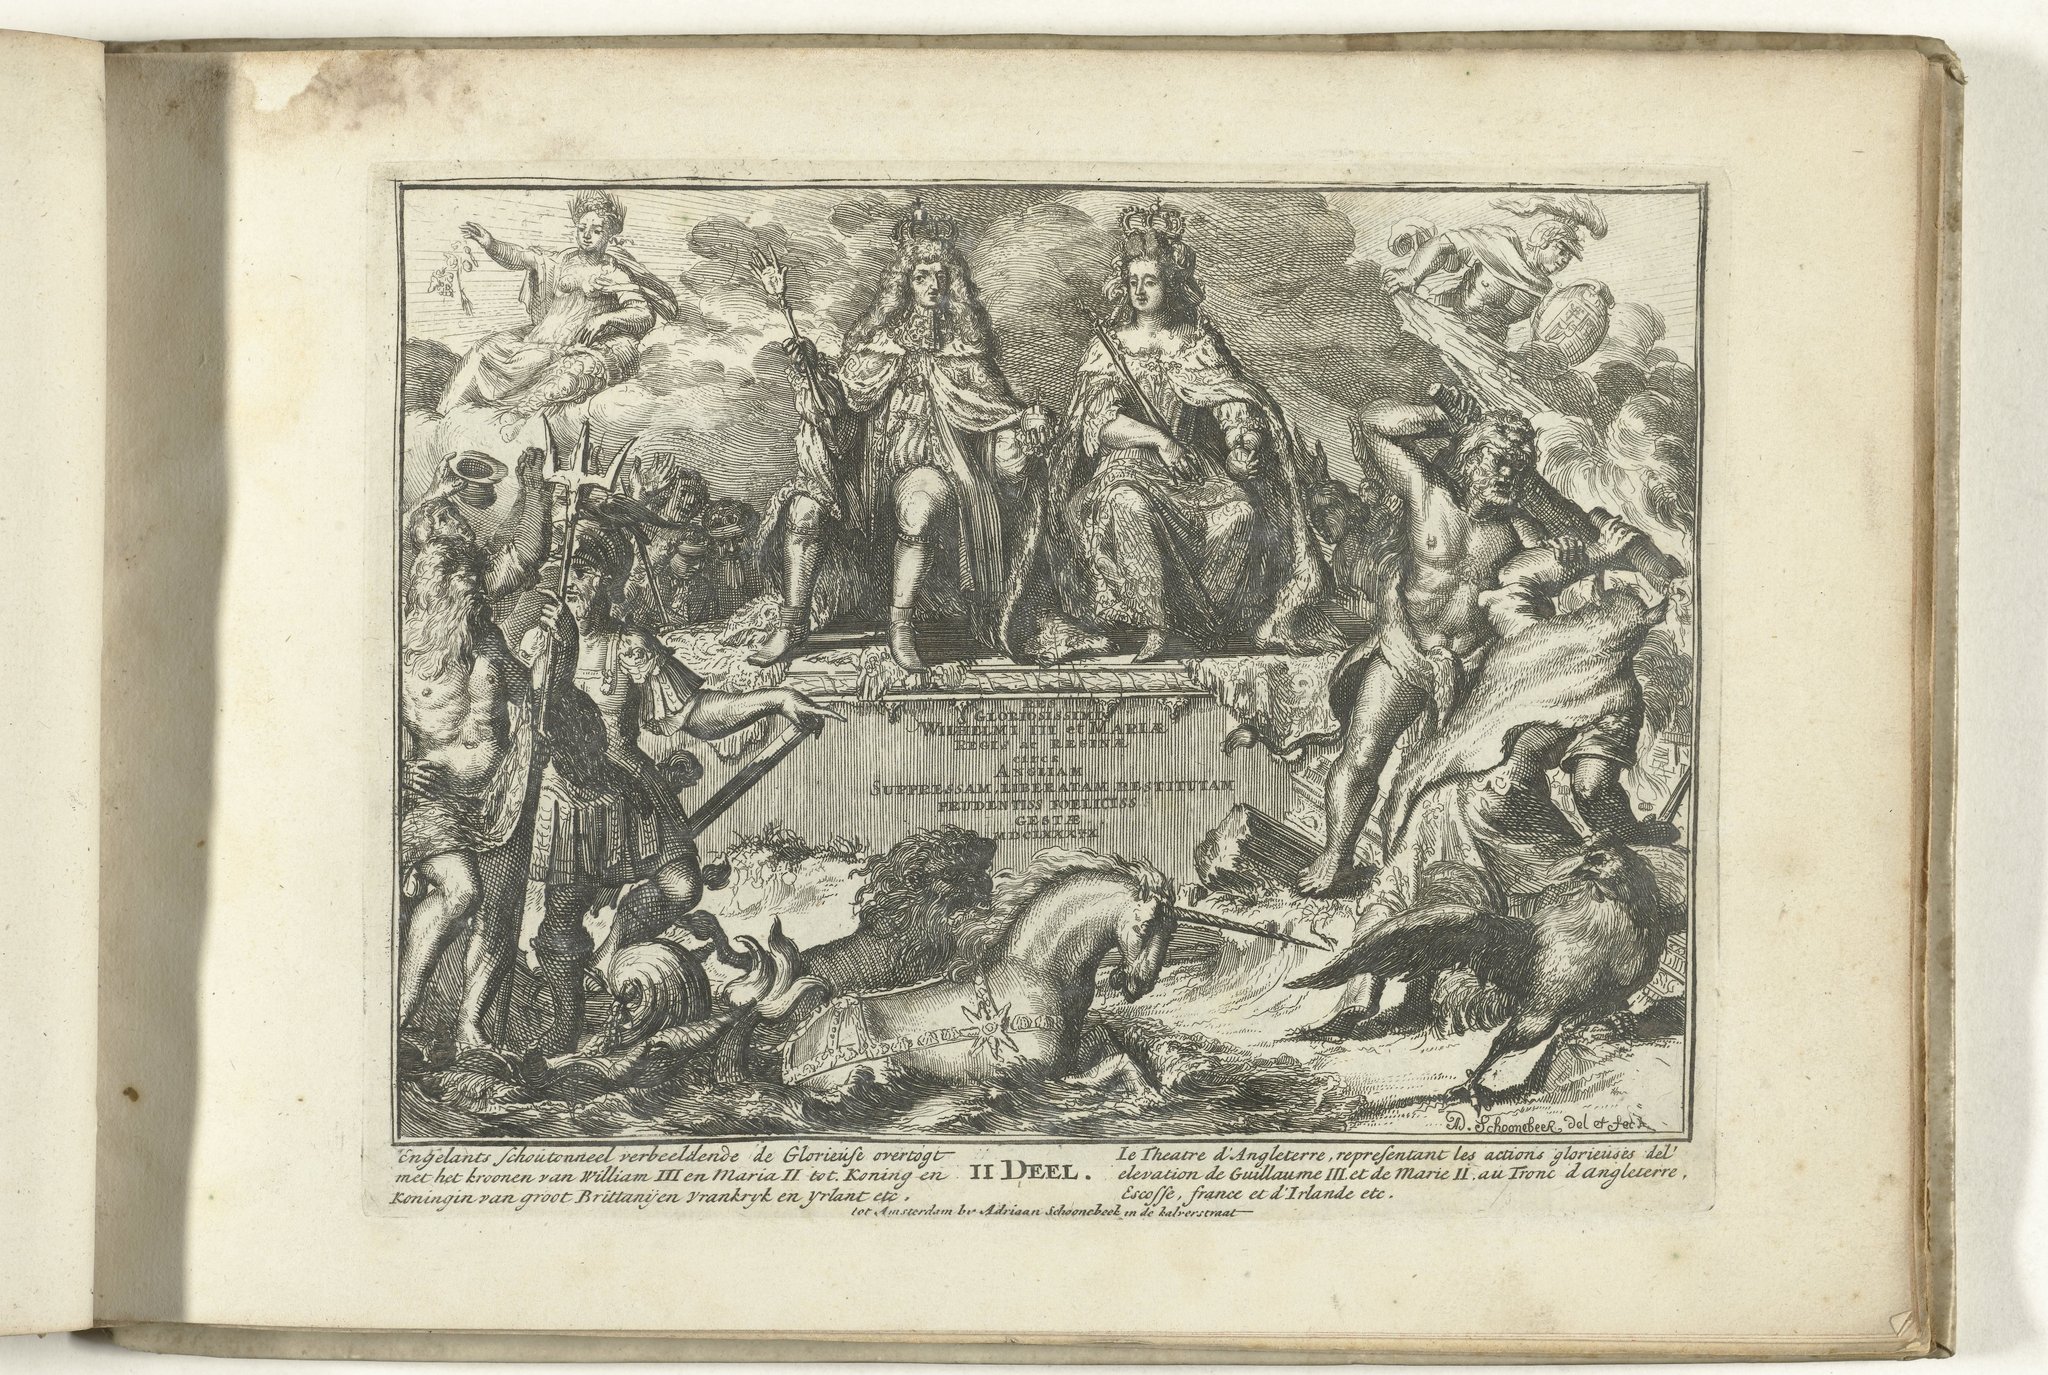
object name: titelprent, frontispice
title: Engelants schoutoneel verbeeldende de Glorieuse overtogt met het kroonen van William III en Maria II tot Koning en Koningin van groot Brittany en Vrankryk en Yrlant, etc. II Deel.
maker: adriaen schoonebeek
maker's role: print maker, publisher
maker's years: 1661-1705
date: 1689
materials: paper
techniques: etching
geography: amsterdam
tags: william iii (prince of orange and king of england, scotland, and ireland), london, maria ii stuart (koningin van engeland, schotland en ierland), title-page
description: Allegorische titelprent met koning Willem III en koningin Maria II Stuart op hun tronen omringd door goden en allegorische figuren. Rechts wordt de Franse haan verjaagd. Titelpagina van de serie 'Engelants schouwtoneel' over de Glorious Revolution 1688-1689 (tweede deel). Met onderschriften in het Nederlands en Frans.